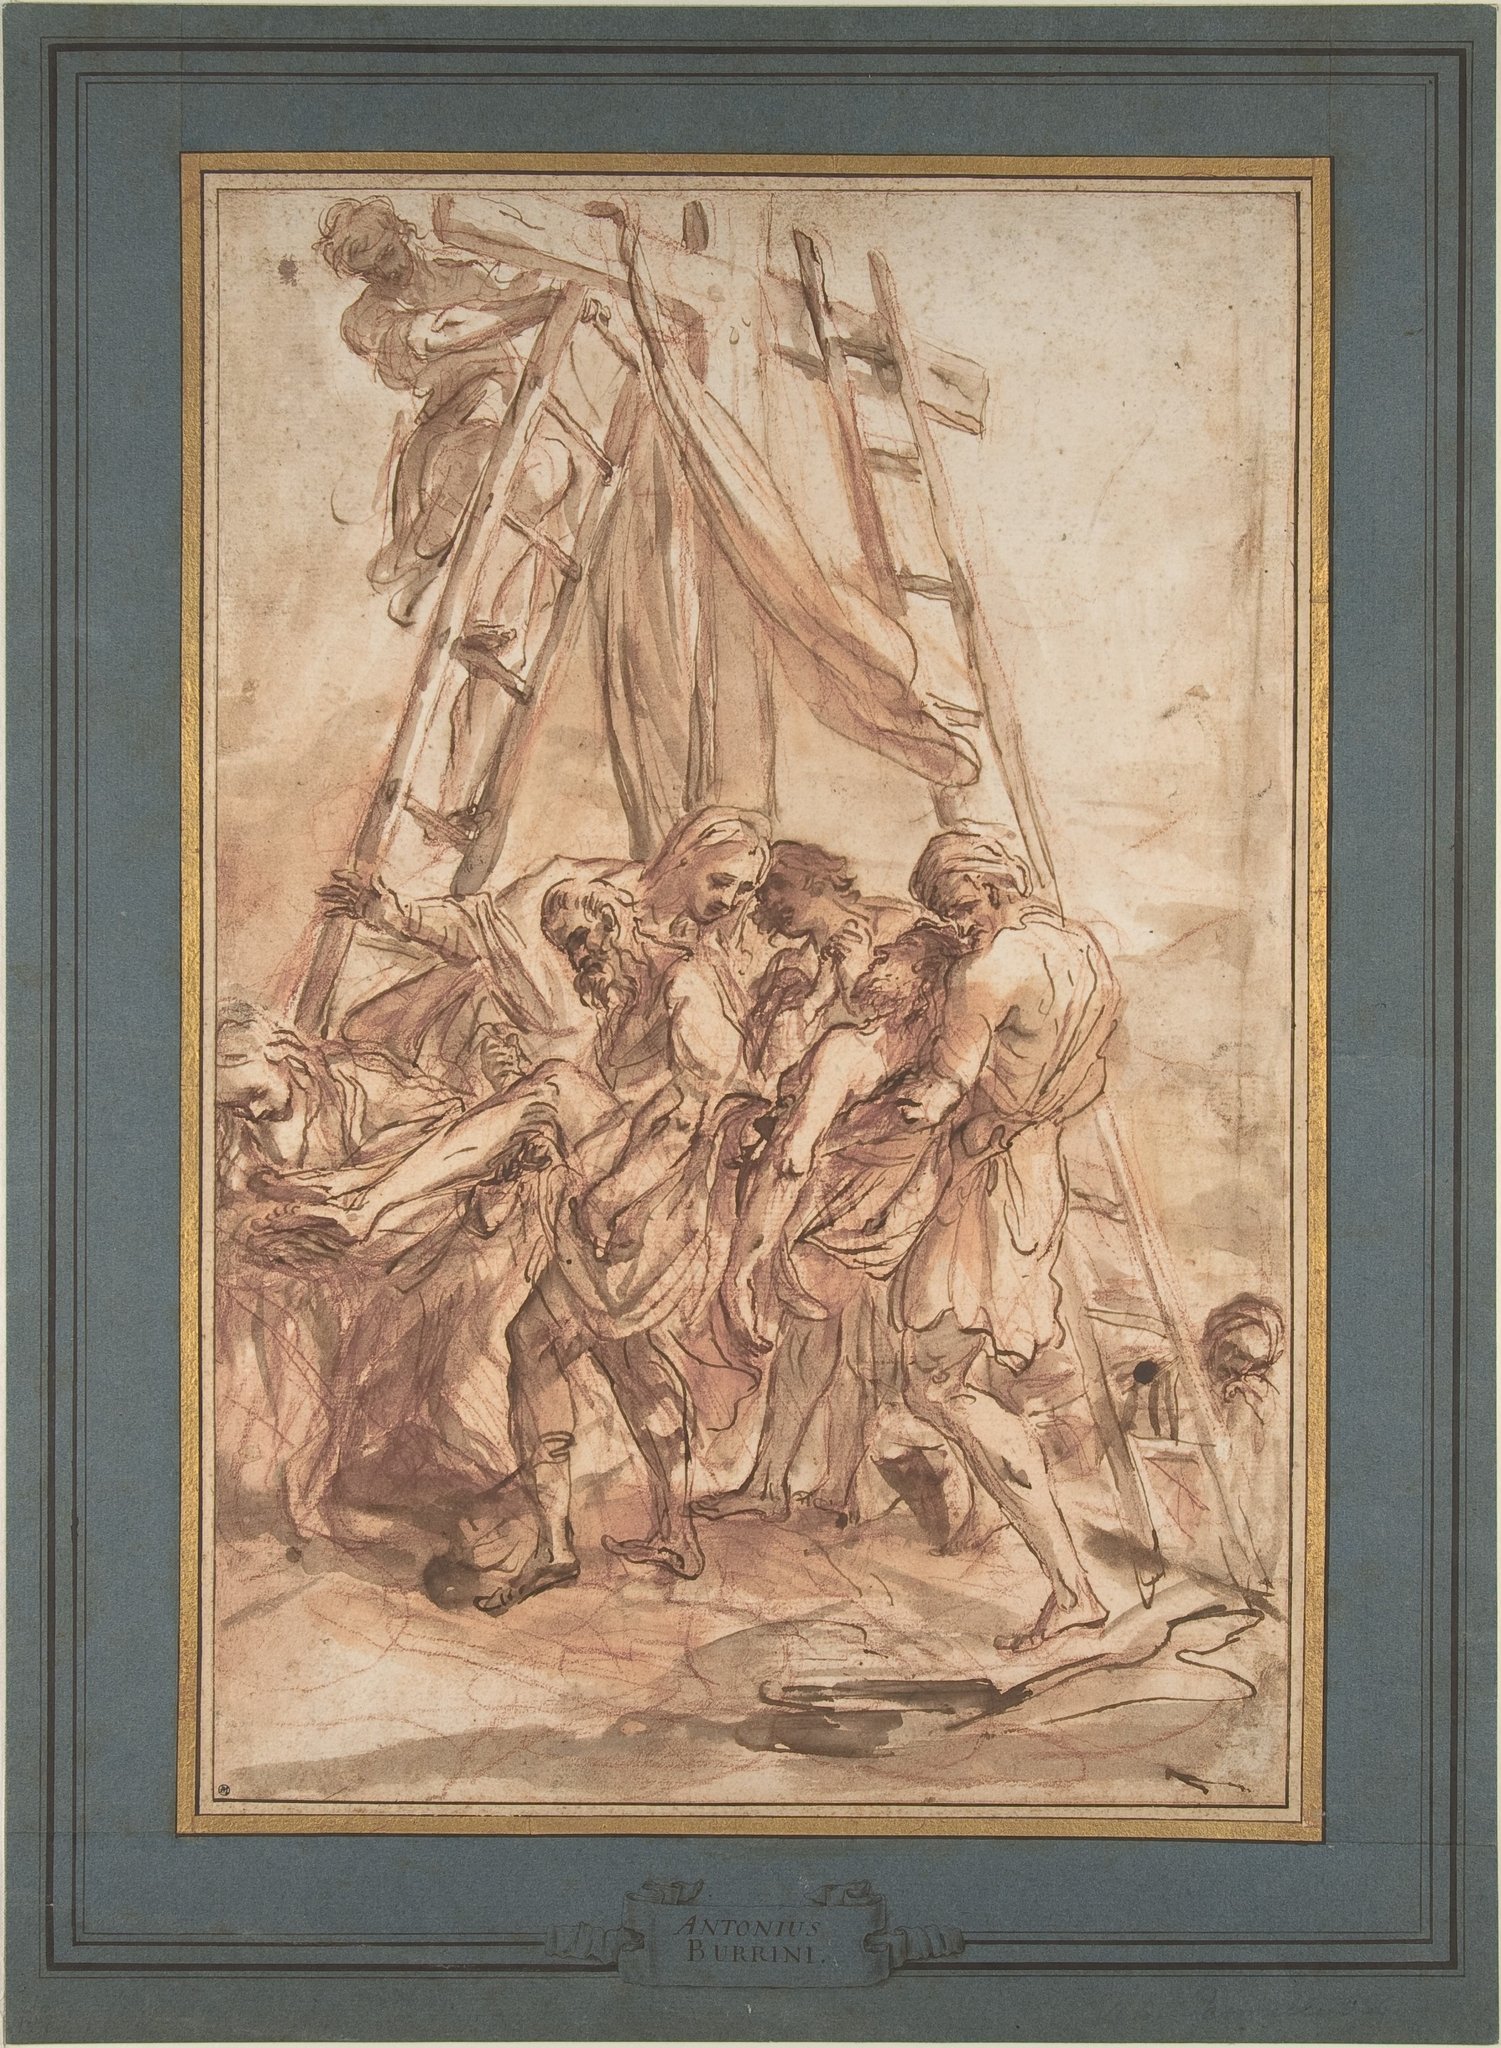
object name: drawing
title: The Descent from the Cross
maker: gian antonio burrini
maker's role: artist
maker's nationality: italian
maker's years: 1656-1727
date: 1720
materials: chalk, ink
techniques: brush, pen, wash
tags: cross,descent from the cross,ladders